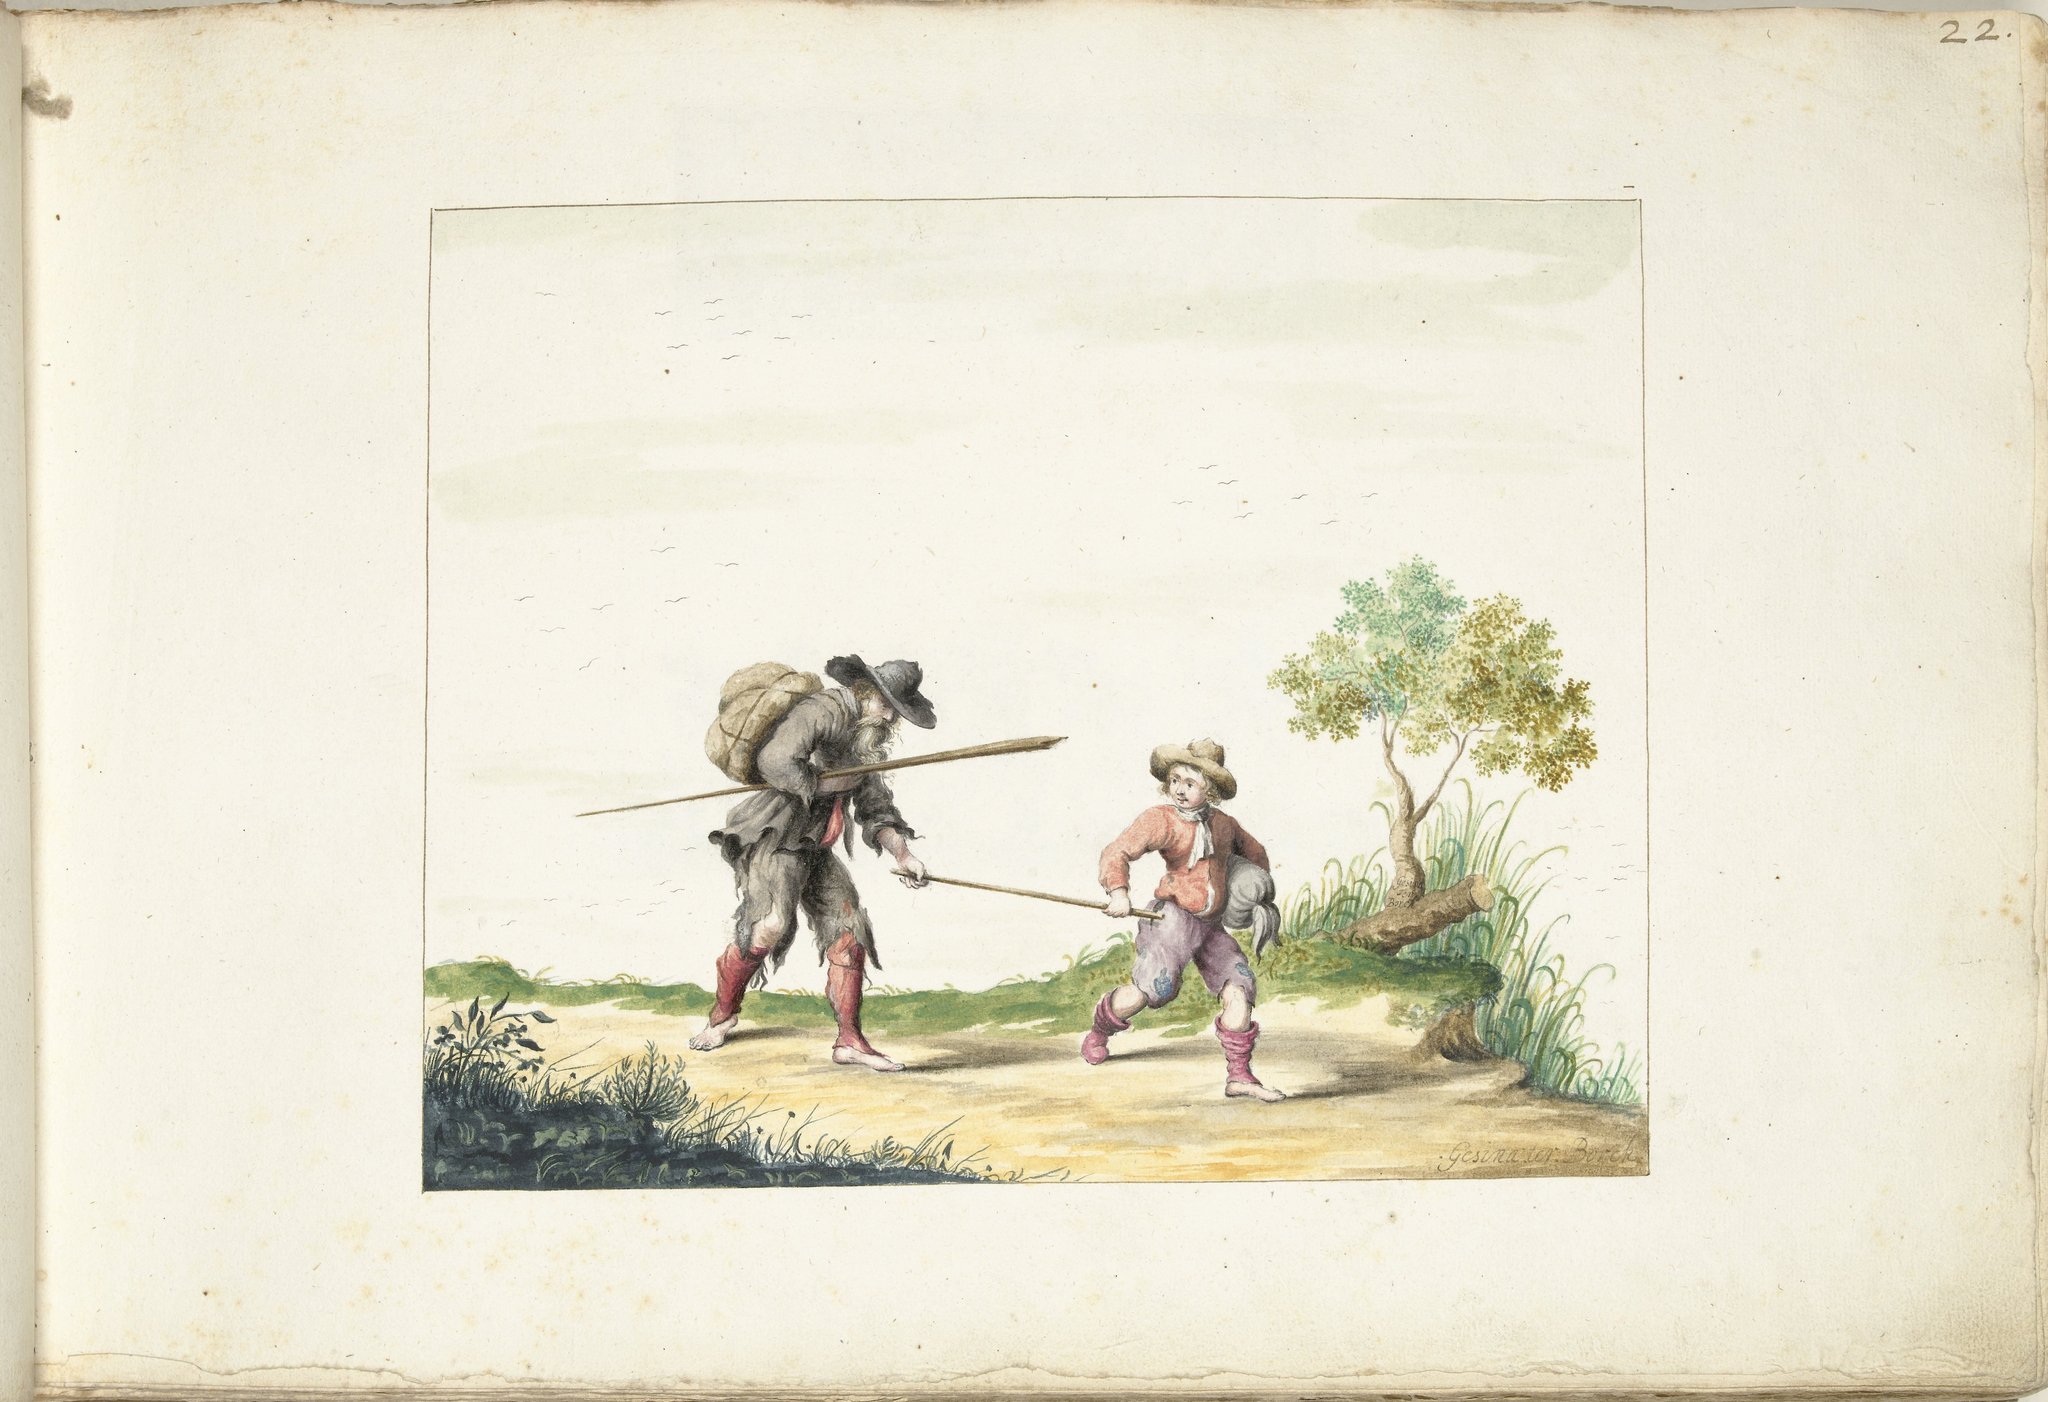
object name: watercolor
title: Oude blinde bedelaar geleid door een jongen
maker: gesina ter borch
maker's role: draughtsman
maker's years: 1633-1690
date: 1660-1687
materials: ink, paper, watercolor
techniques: brush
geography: zwolle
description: Oude blinde bedelaar geleid door een jonge gids.